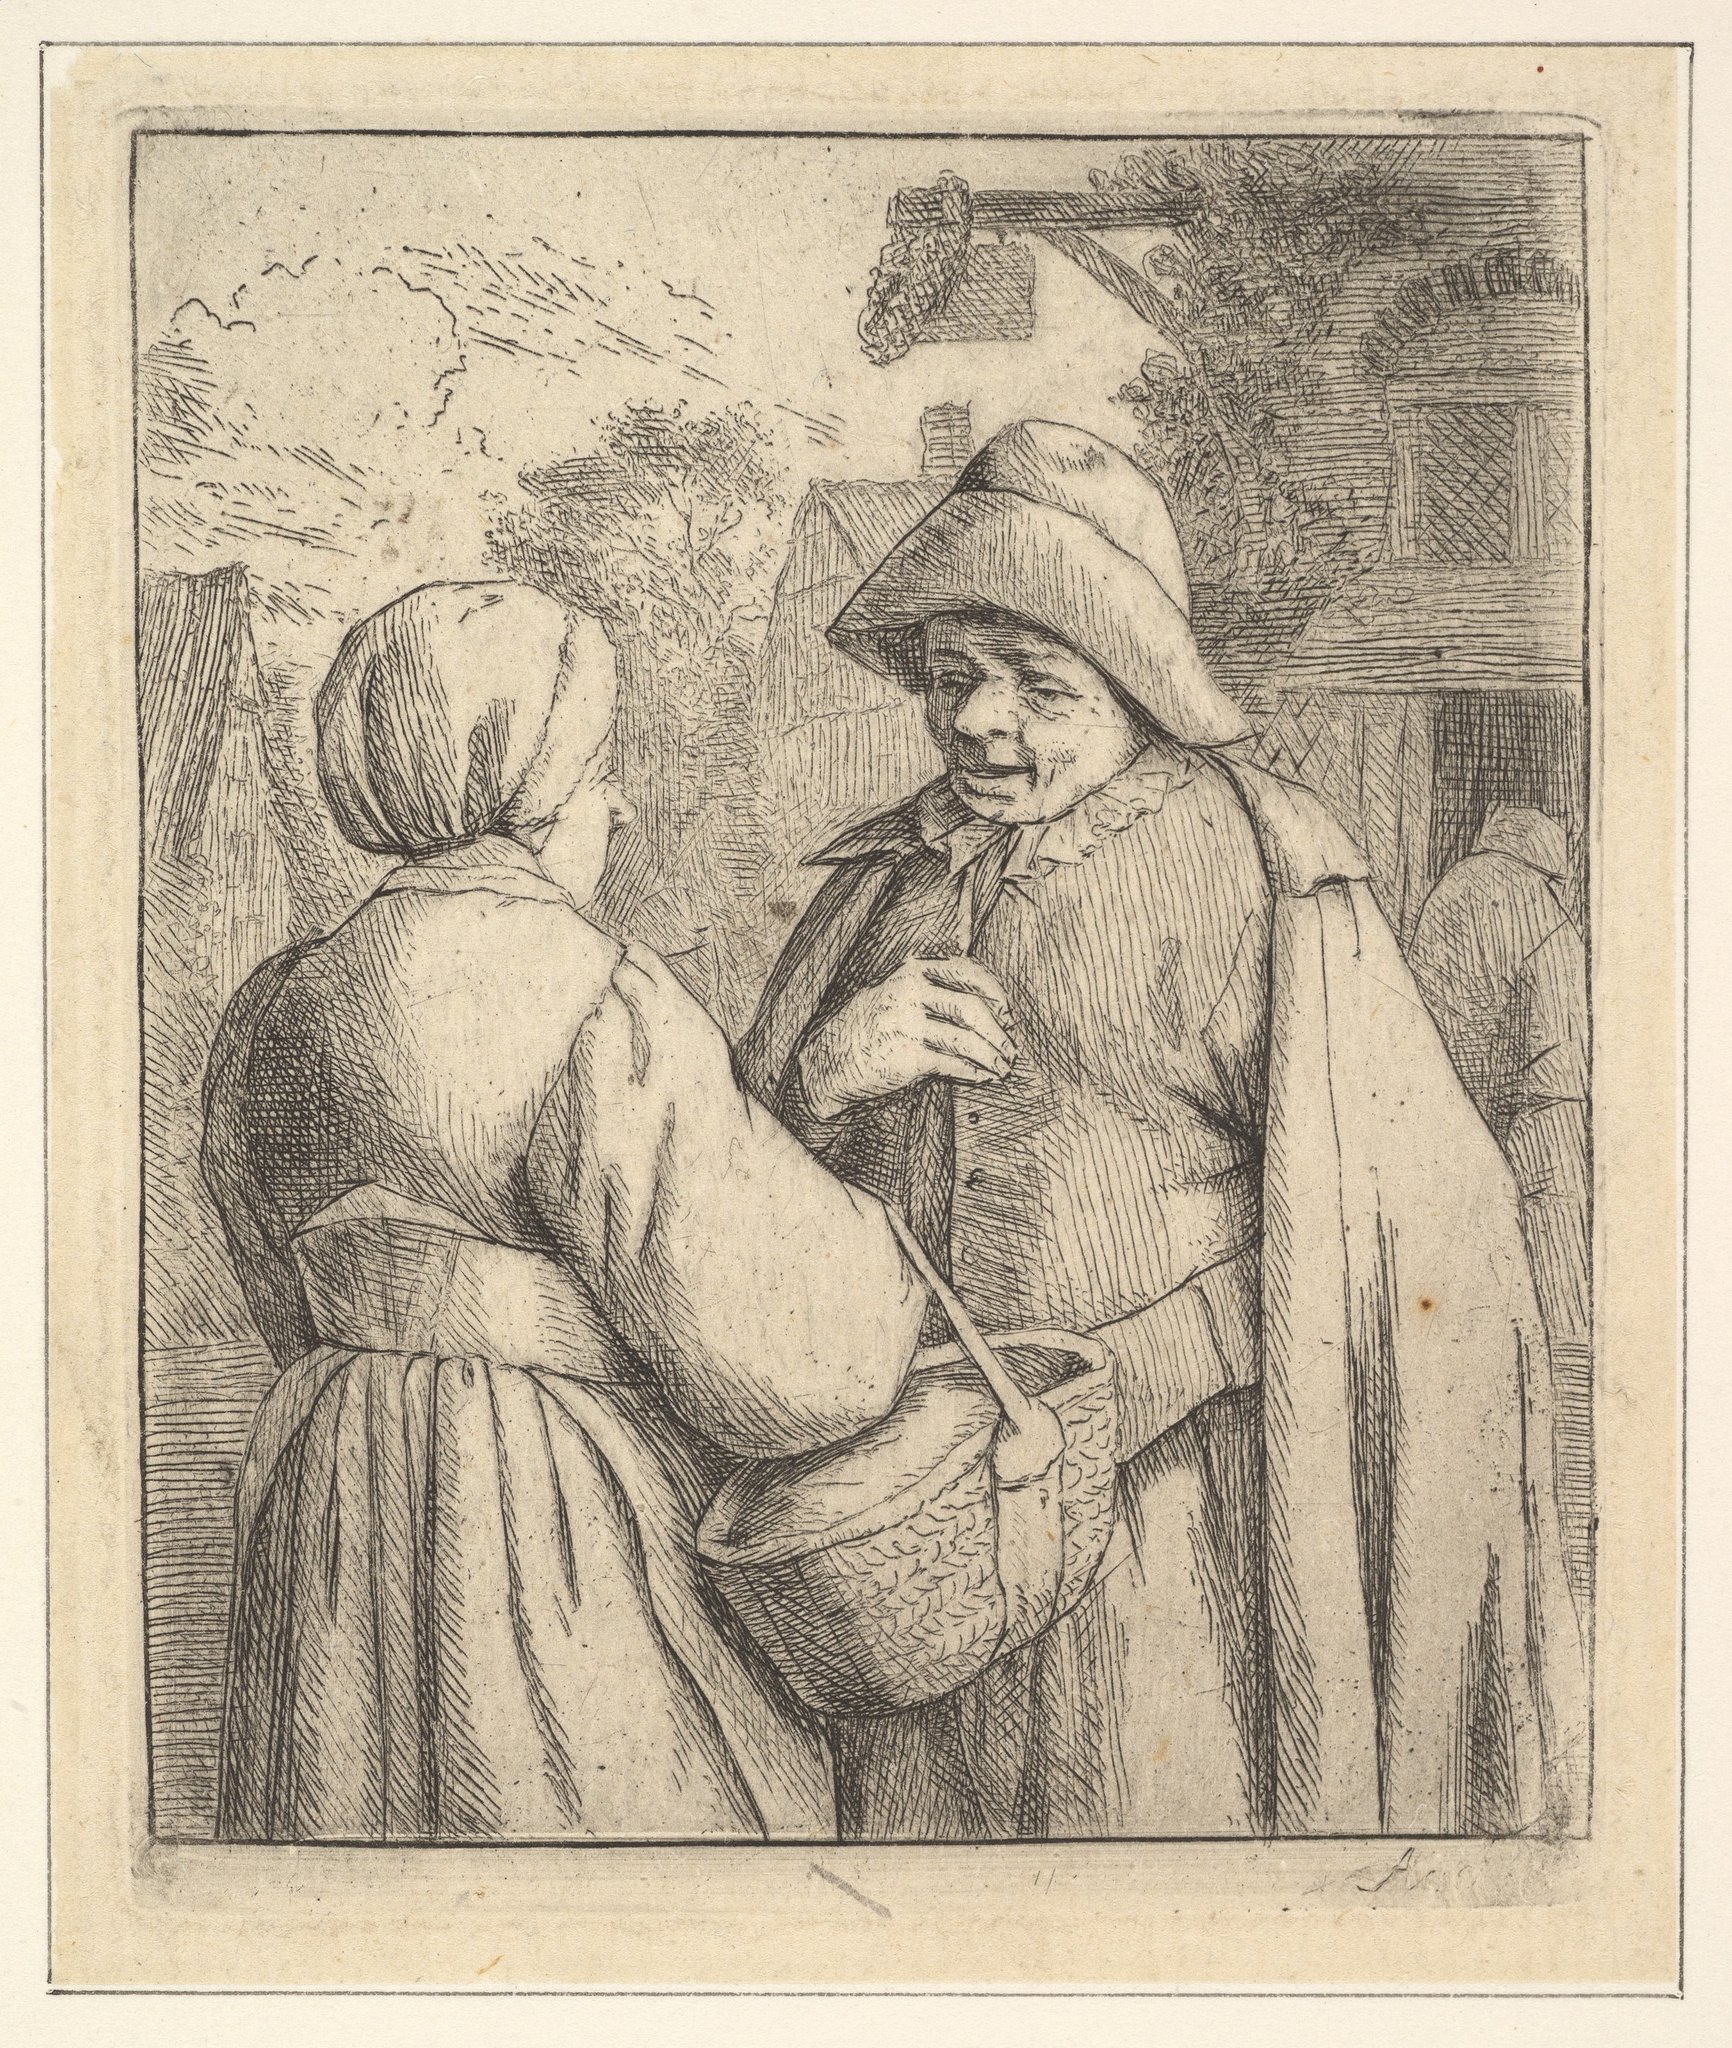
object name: print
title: Conversation in the Street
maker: adriaen van ostade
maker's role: artist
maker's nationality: dutch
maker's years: 1610-1685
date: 1610-1685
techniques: etching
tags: women,street scene